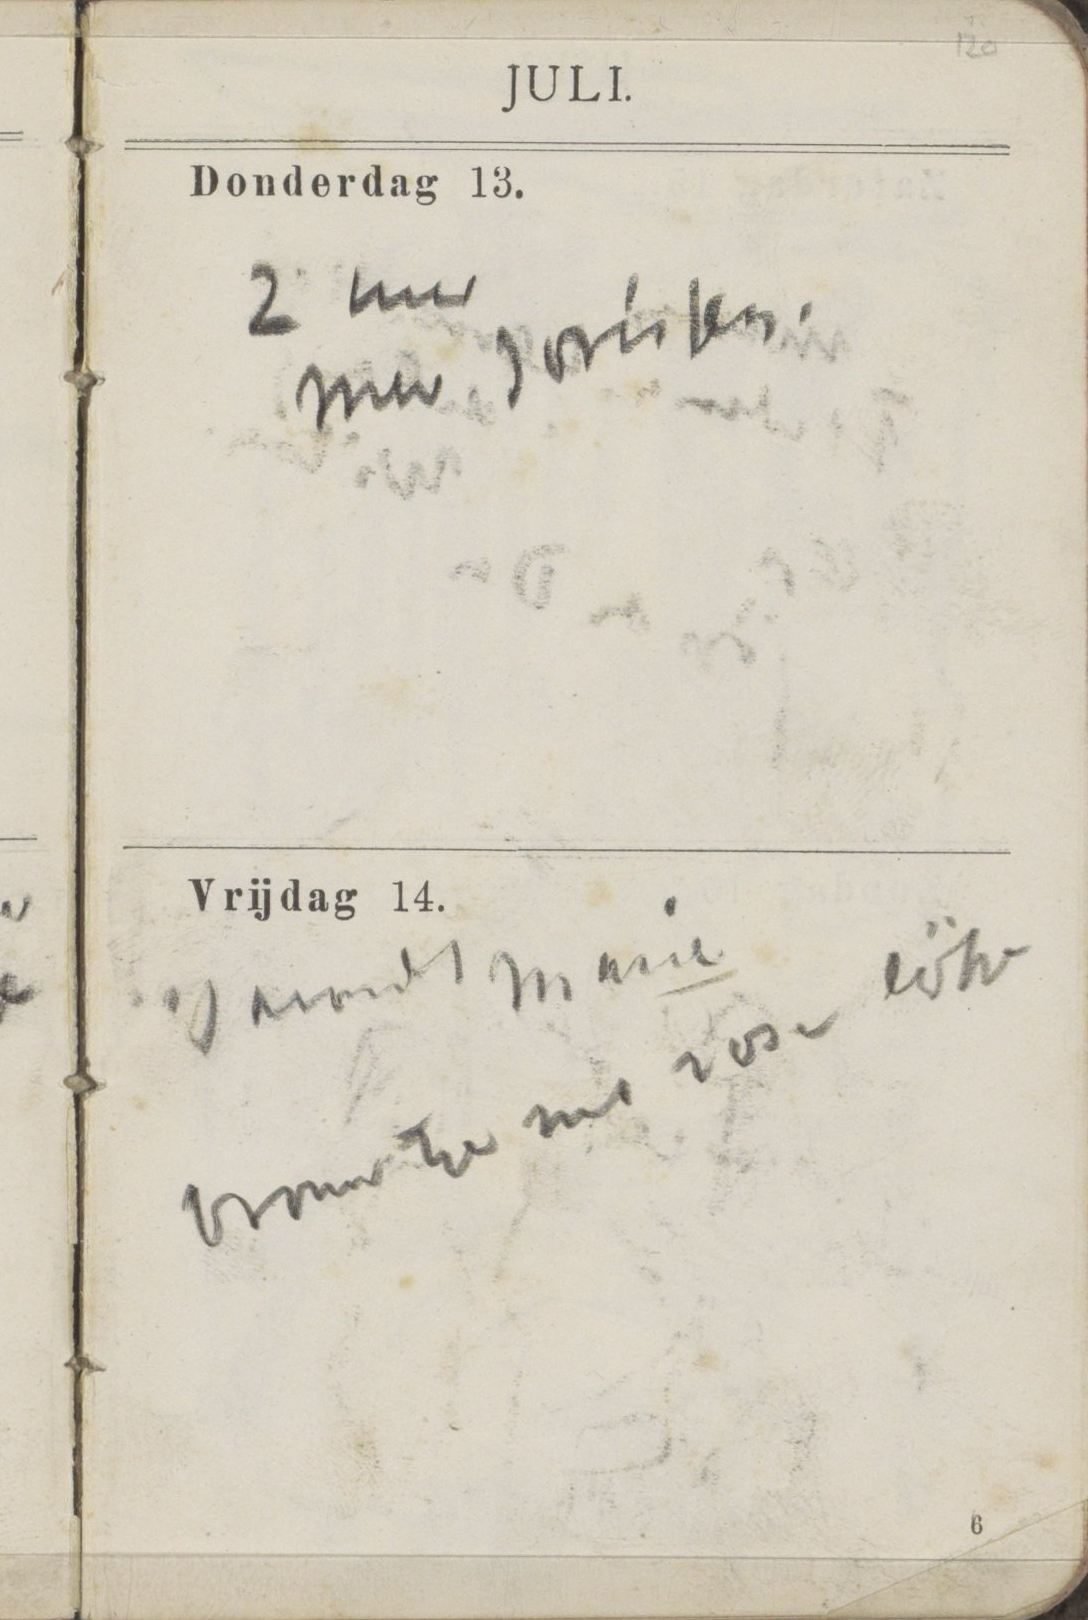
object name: sketchbook leaf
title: Annotaties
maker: george hendrik breitner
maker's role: draughtsman, painter, print maker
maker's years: 1857-1923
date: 1893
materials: chalk, paper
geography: amsterdam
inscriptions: annotation: ‘2 uur/ Mev Jorissen/ 's avonds Marie/ vrouwtje met rose [...]’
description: Pagina 120 uit een als schetsboek gebruikte agenda met 108 bladen.